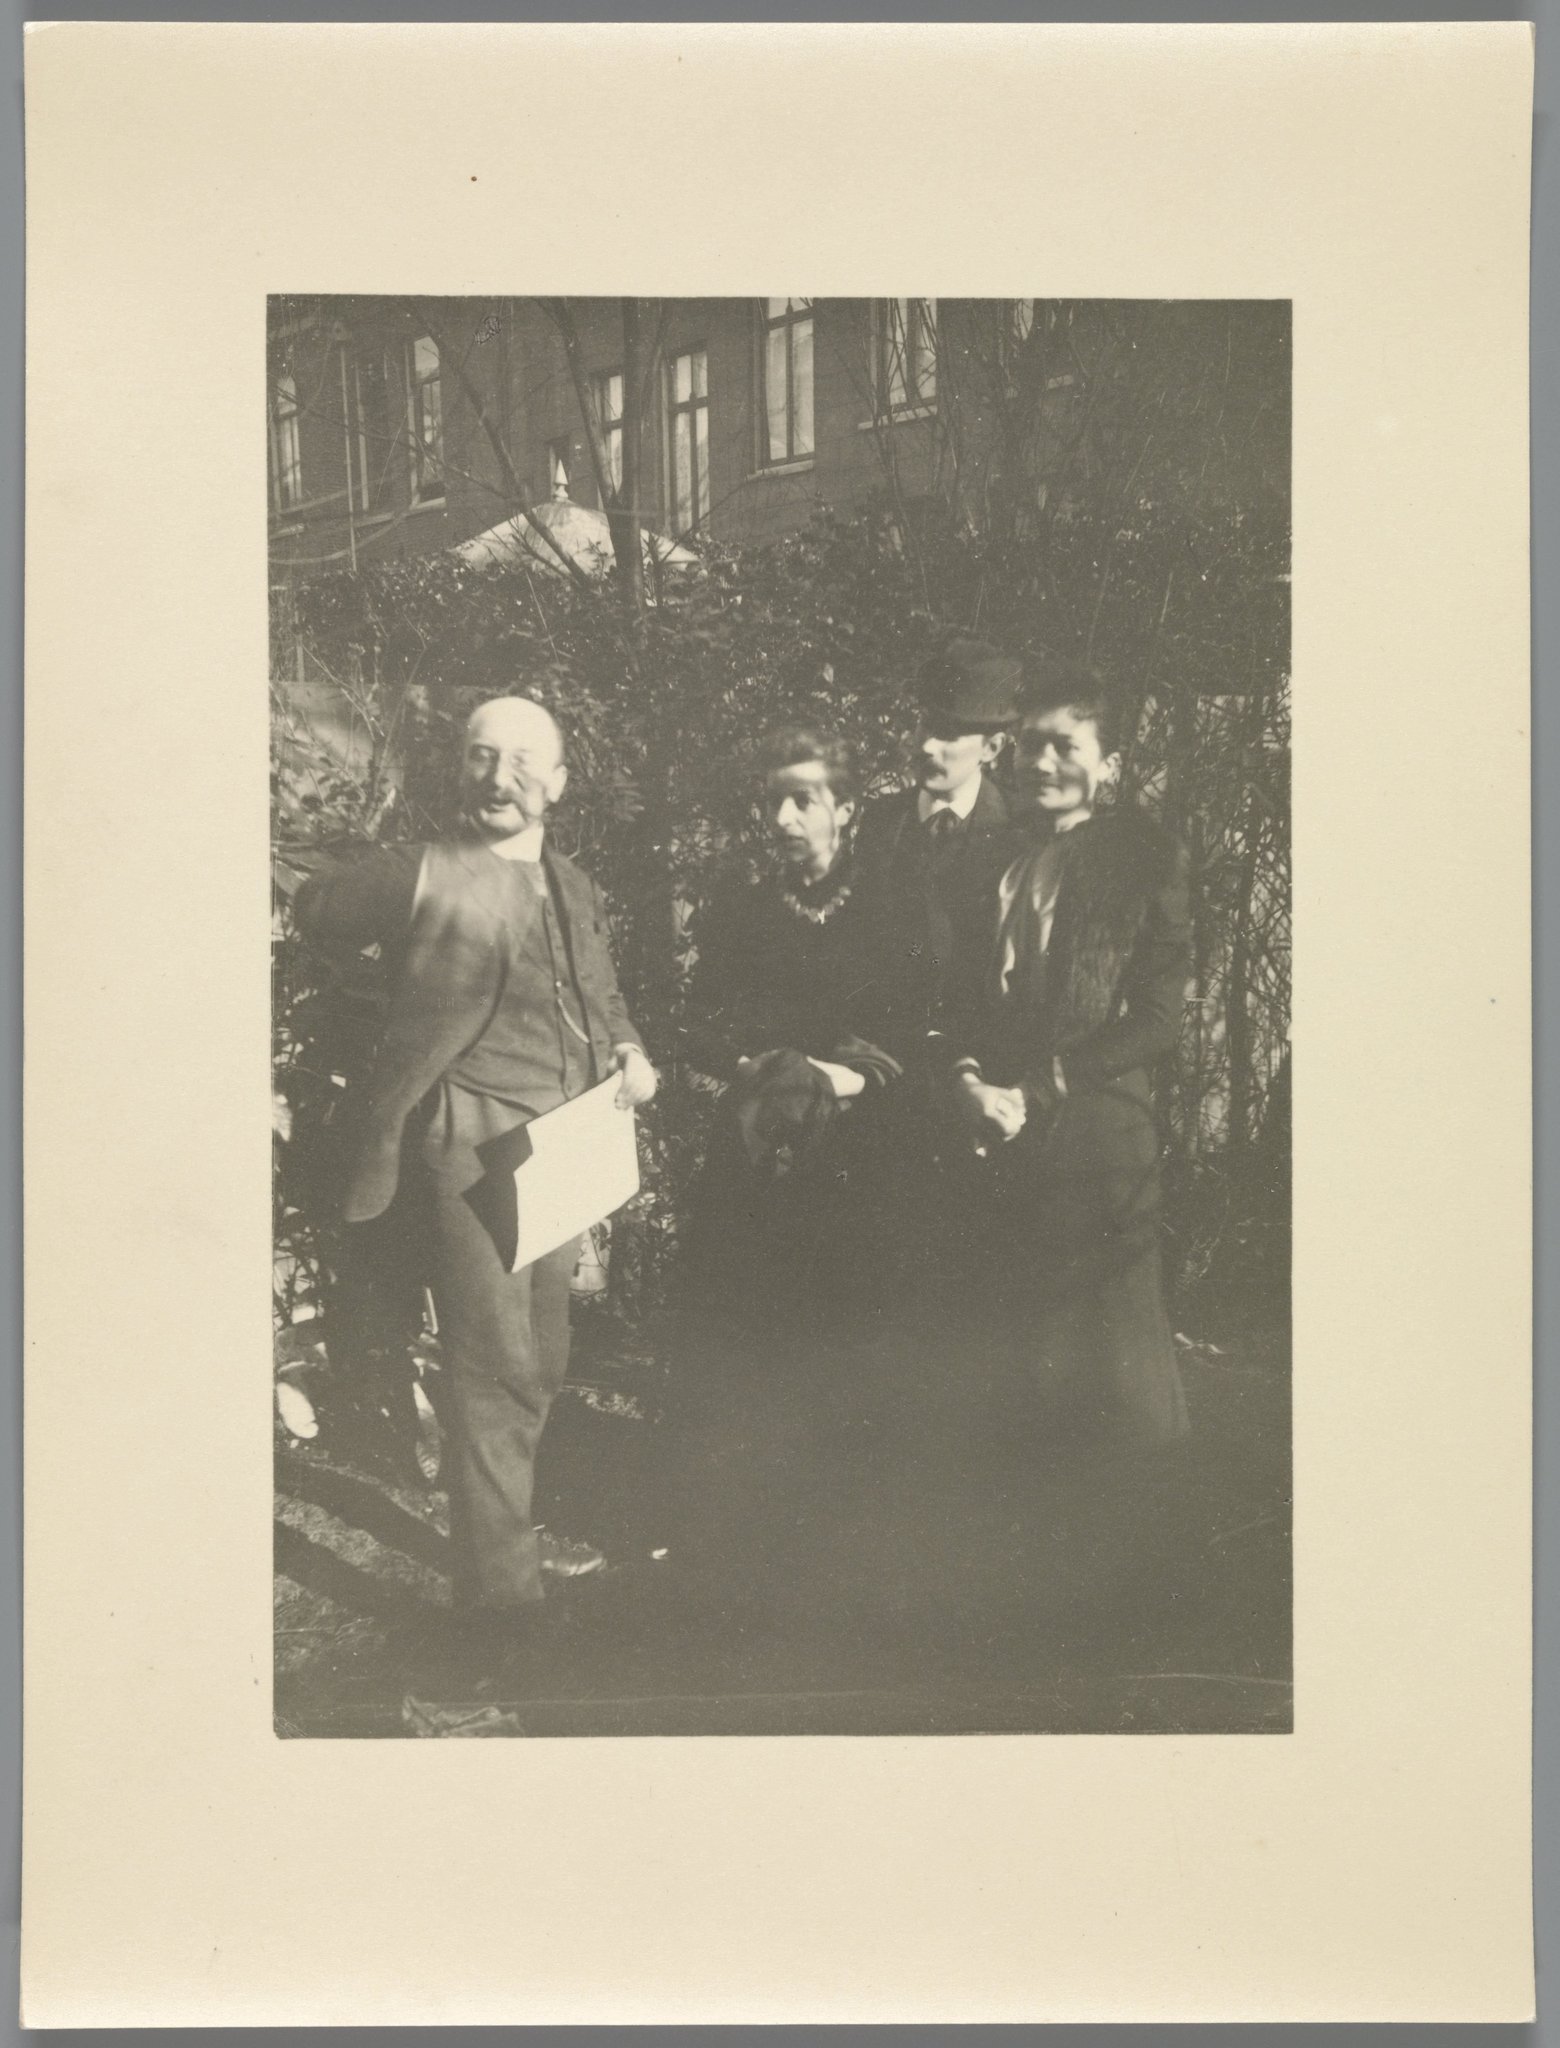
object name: photograph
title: Reproductie naar een foto van Willem Witsen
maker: Anonymous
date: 1860-1915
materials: paper, photographic support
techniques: gelatin silver print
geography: netherlands